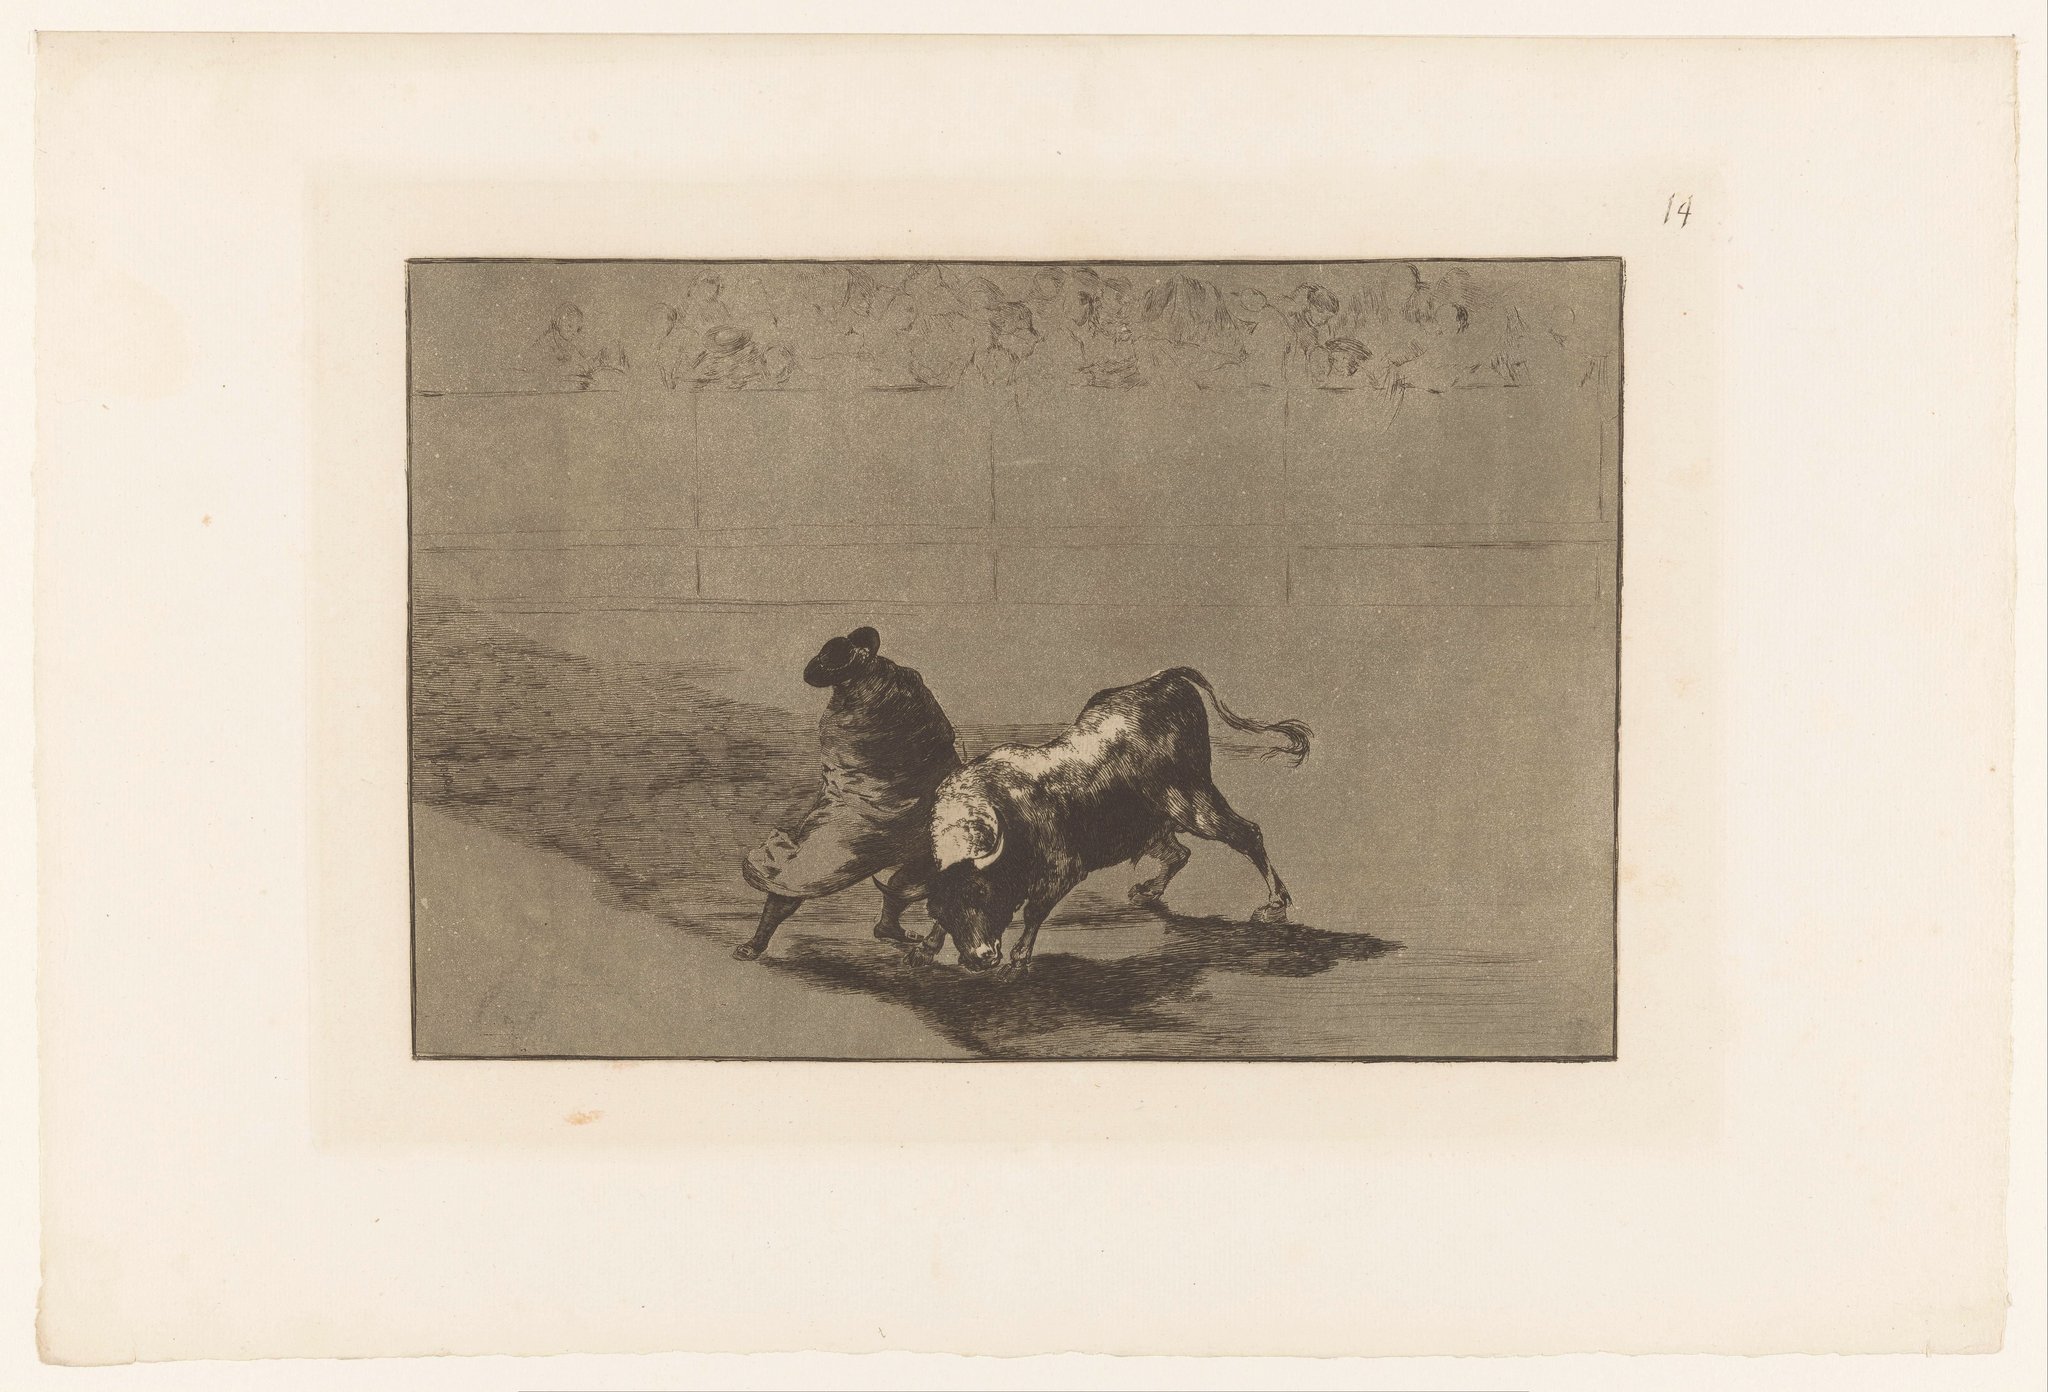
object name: print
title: Stierengevechten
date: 1876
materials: paper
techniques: aquatint, etching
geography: paris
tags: bull, bullfight, bull-fighter, toreador, casting weapons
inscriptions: collector's mark: Lugt 2228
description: Deze prent maakt deel uit van een serie van 40 prenten door Francisco de Goya met voorstellingen van stierengevechten. De eerste editie bestond uit 33 genummerde prenten en werd uitgegeven in 1816. Dit betreft de derde editie, uitgegeven in 1876 door Eugène Loizelet en door hem voorzien van een titelprent en lijst met titels. Naast de 33 prenten publiceerde Loizelet ook de prenten die door Goya op de achterkanten van 7 van de platen werden geëtst. Deze zijn niet voorzien van nummers maar van de letters A-G.